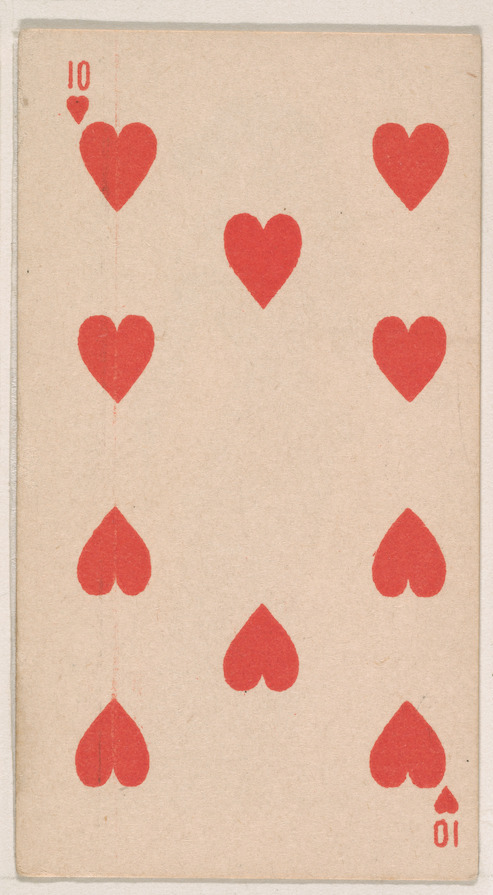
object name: print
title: Ten of Hearts, from the Transparent Playing Cards series (N220) issued by Kinney Bros.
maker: kinney brothers tobacco company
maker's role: publisher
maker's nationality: american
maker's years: 1869-2011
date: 1888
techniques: color lithograph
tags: playing cards